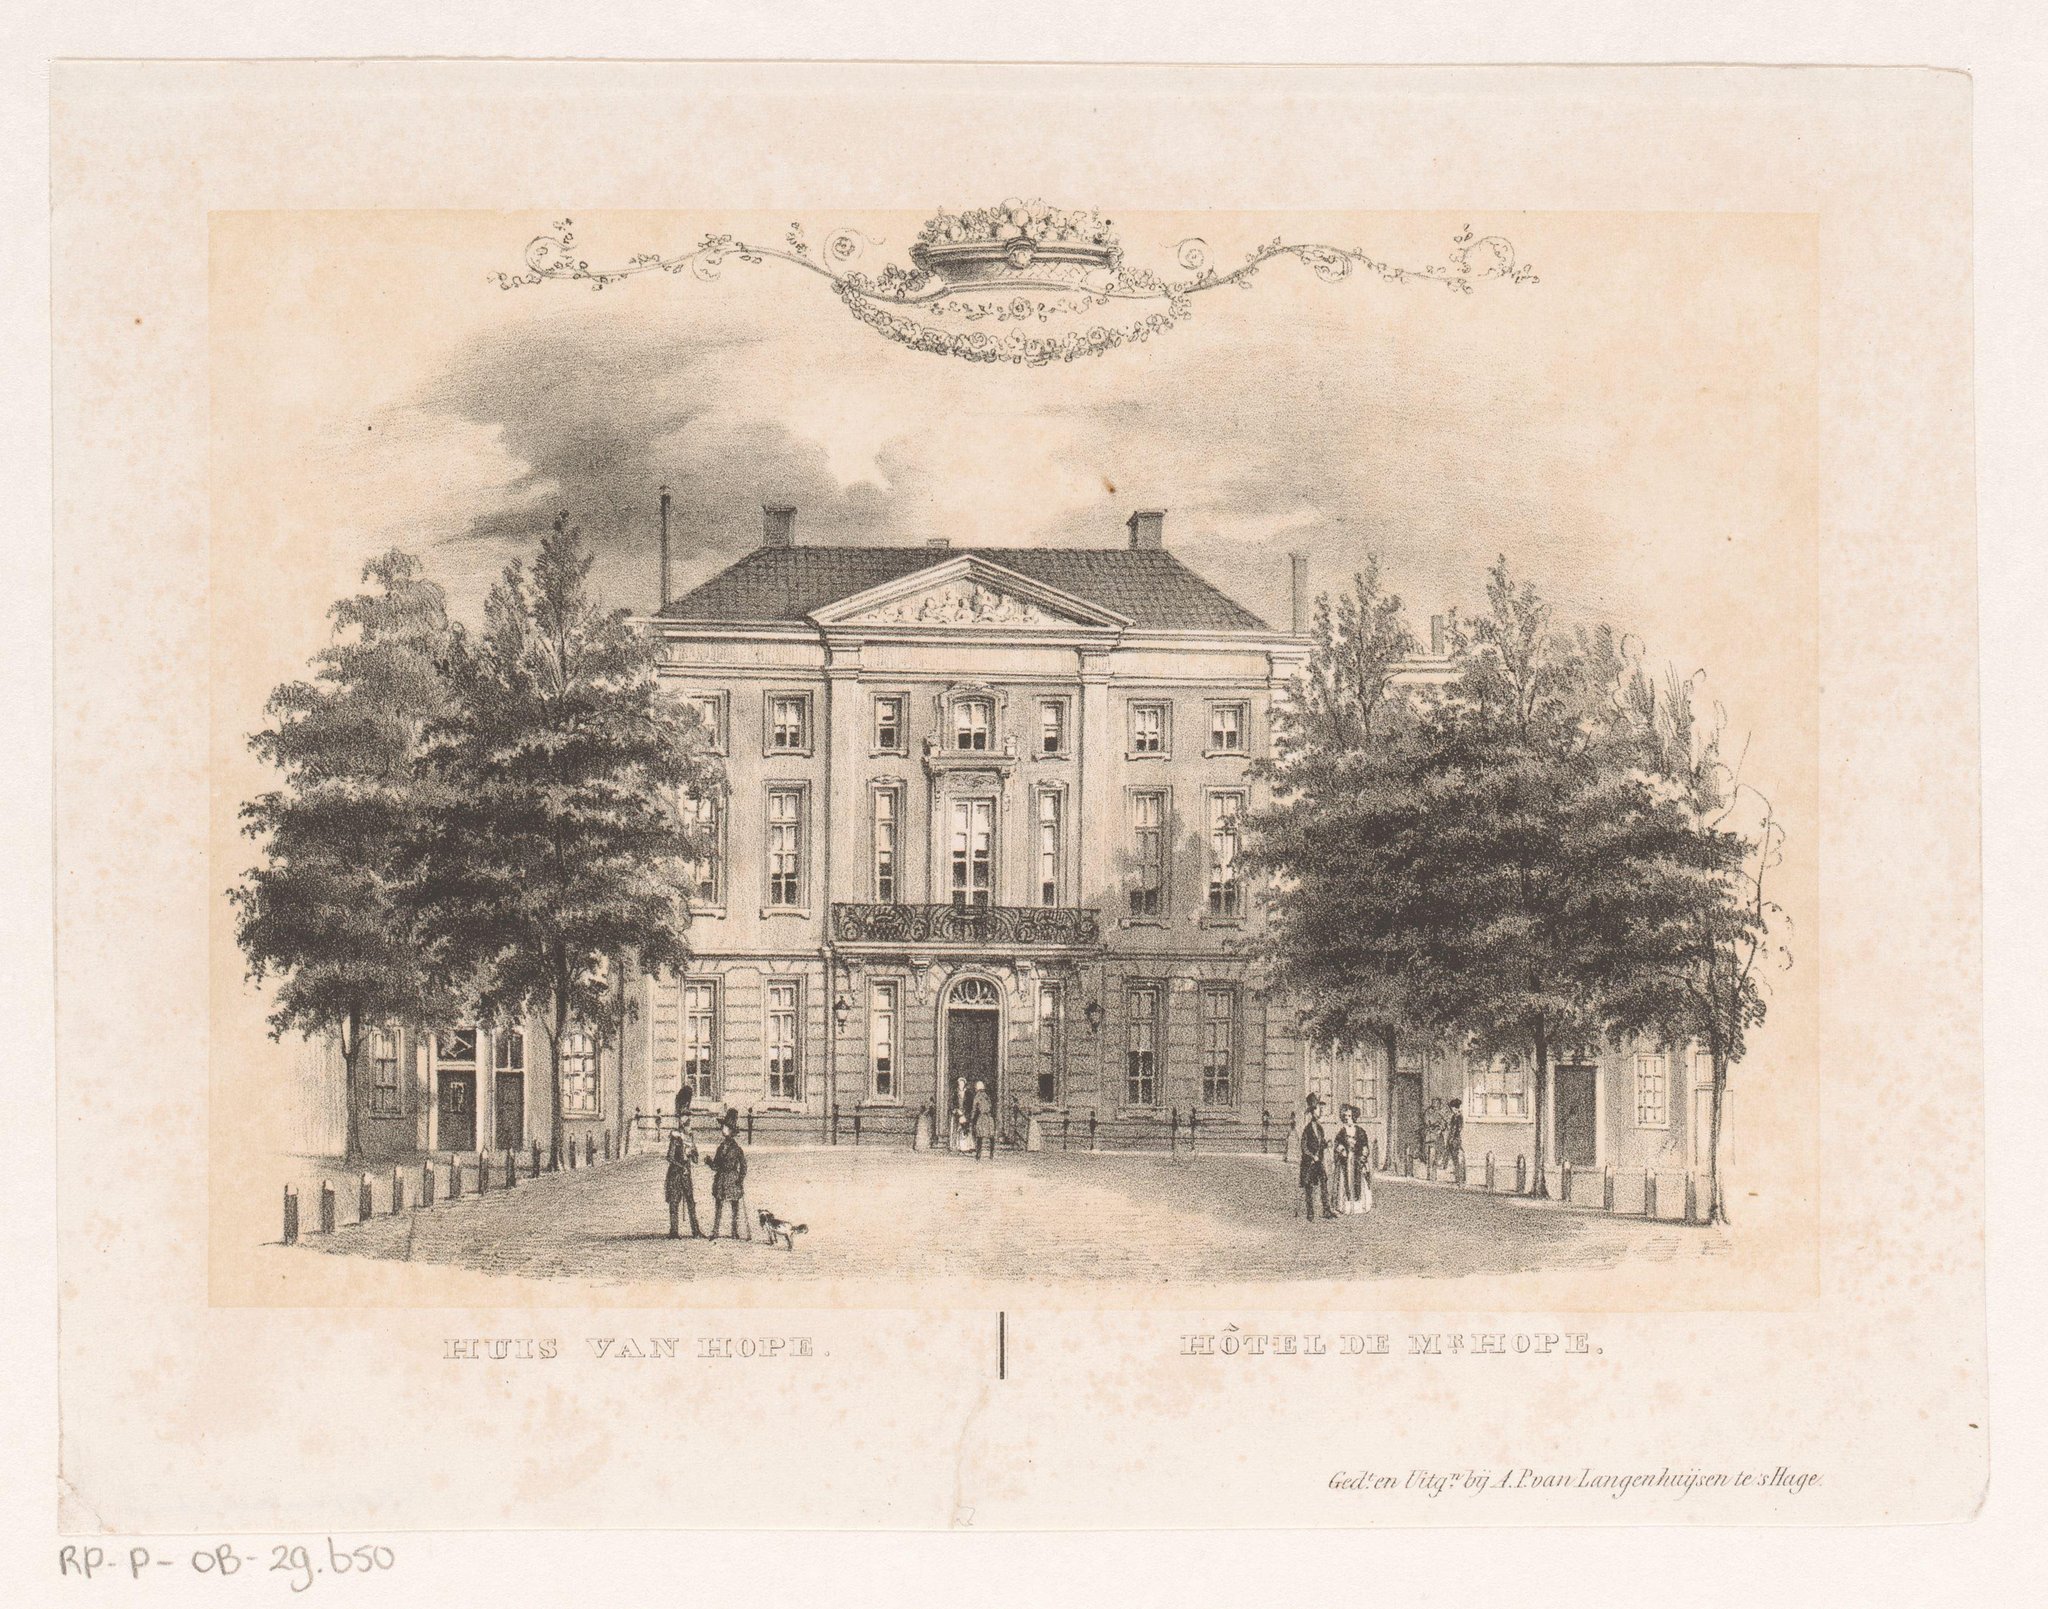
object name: print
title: Huis van Hope / Hôtel de Mr Hope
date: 1830-1846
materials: paper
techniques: tone lithography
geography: the hague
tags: palace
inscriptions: collector's mark: Lugt 2228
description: Hotel Hope, tegenwoordig Paleis Lange Voorhout. Op het plein lopen mensen.